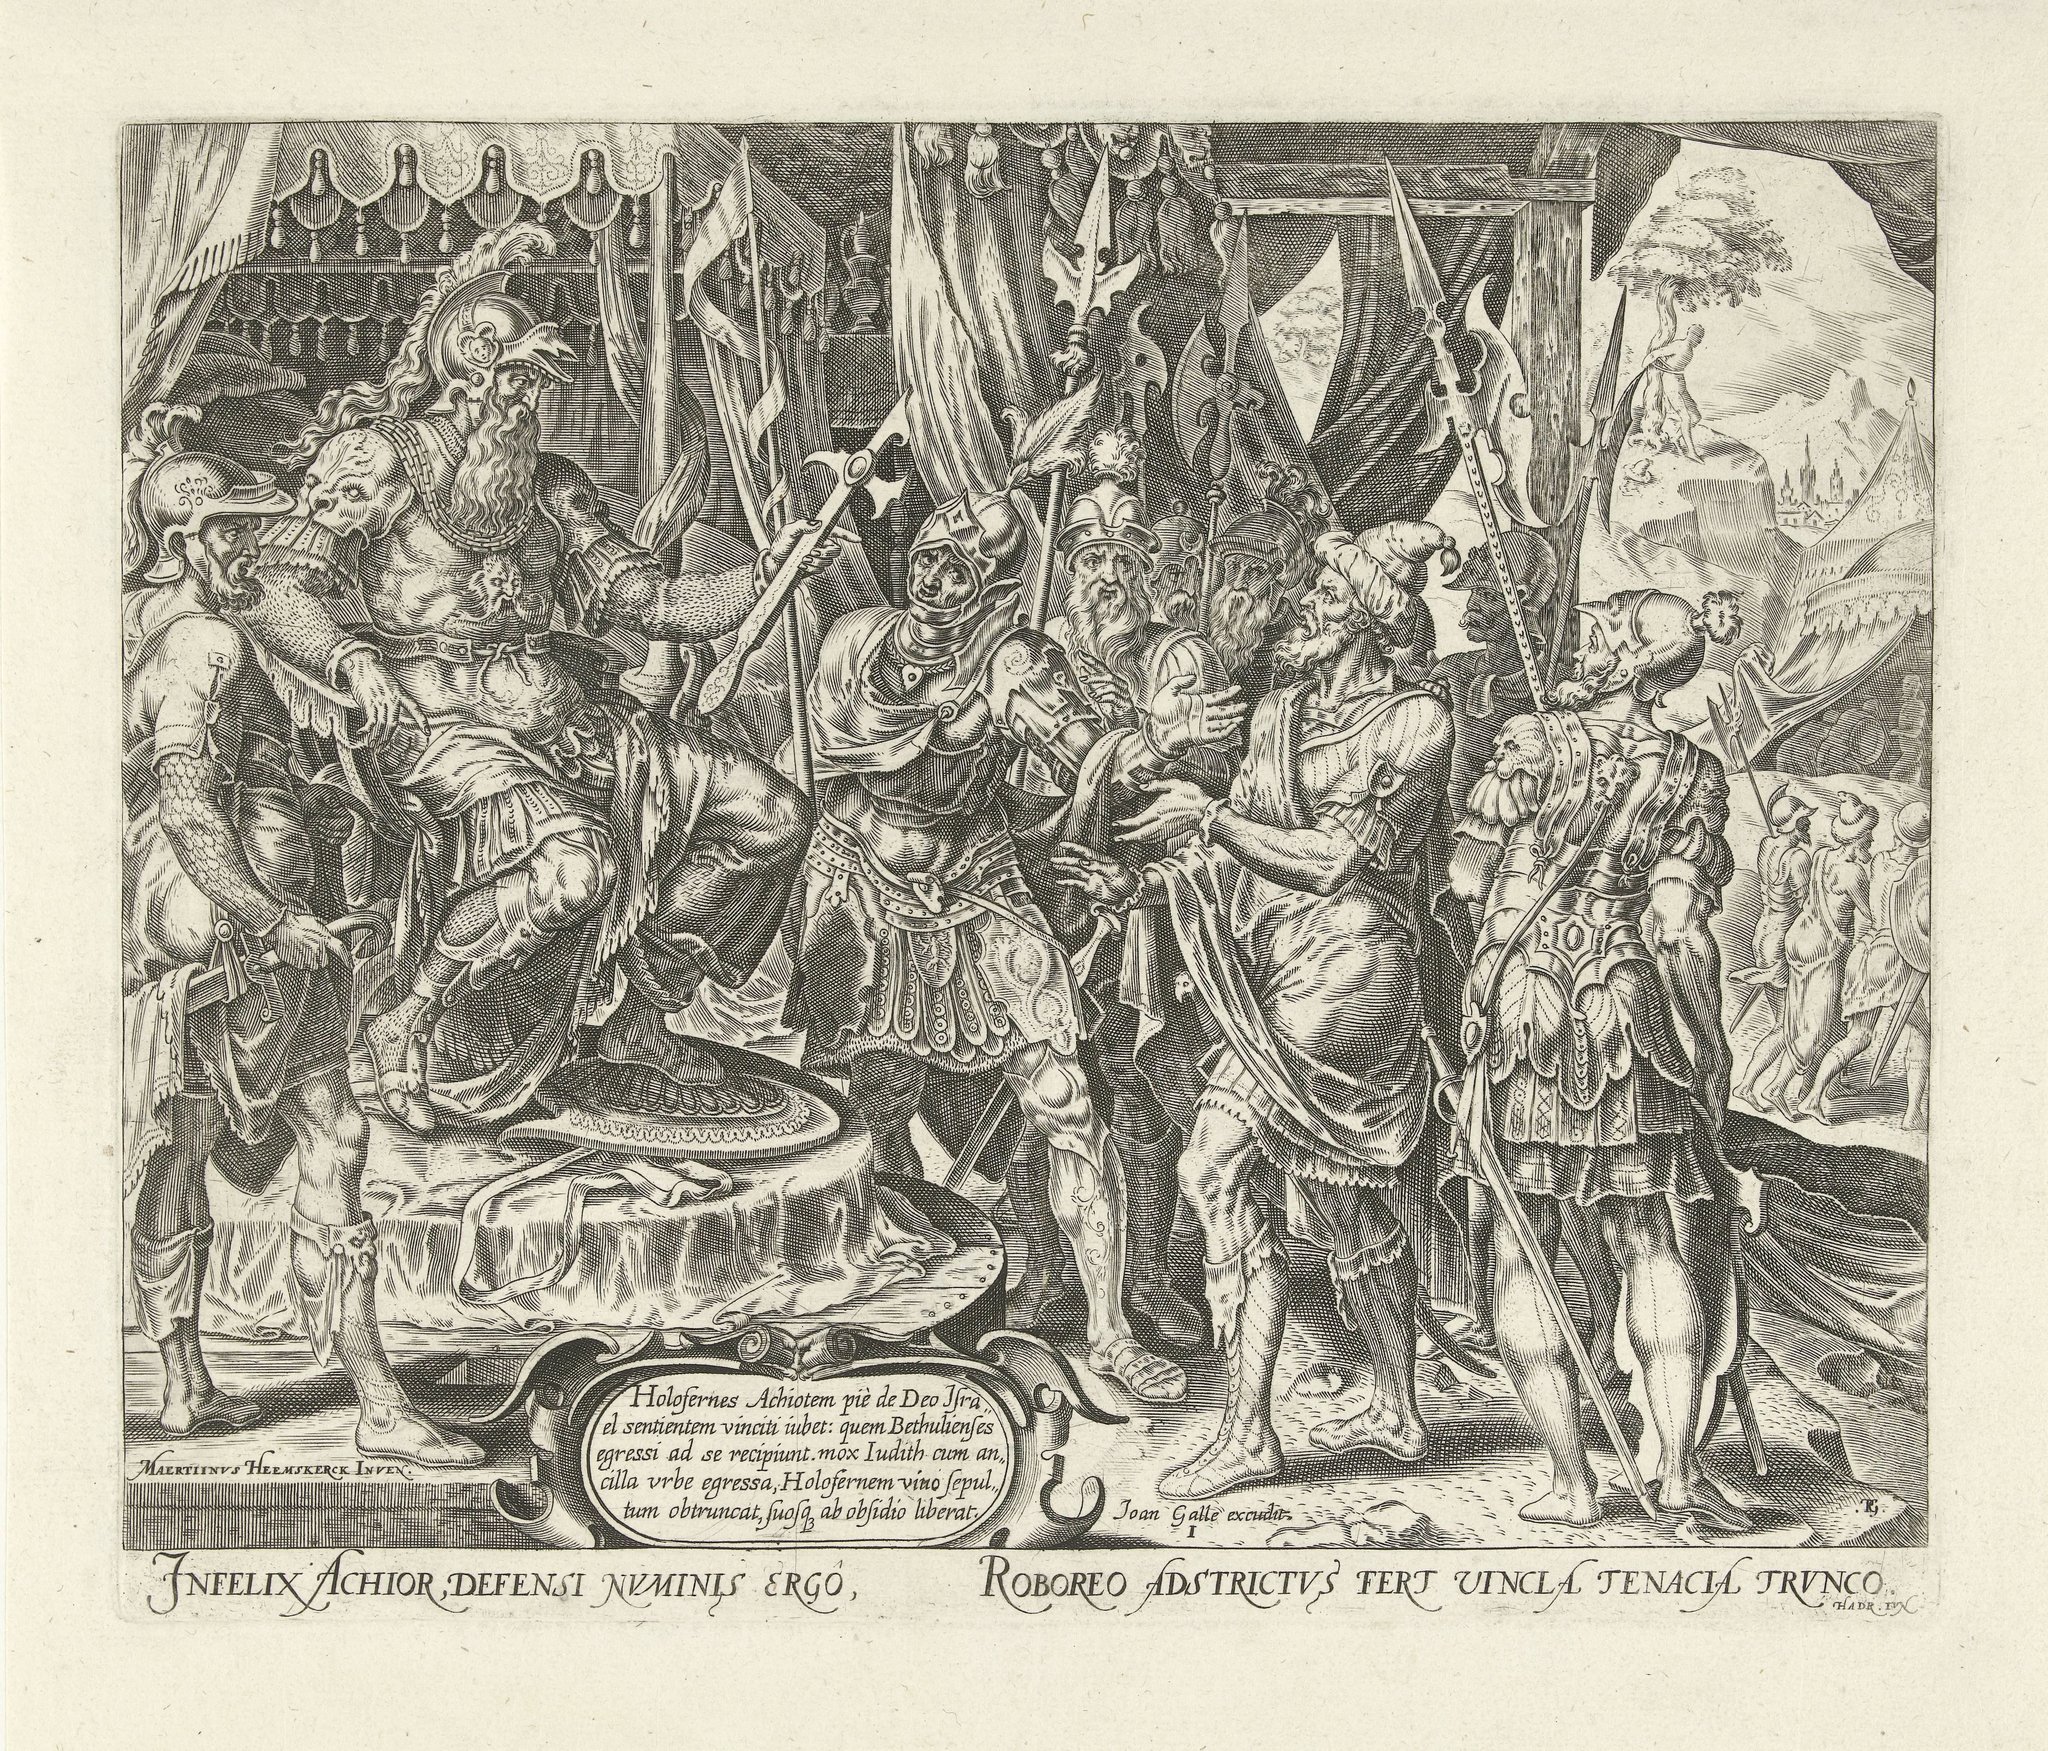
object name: print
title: Geschiedenis van Judit en Holofernes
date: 1627-1678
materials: paper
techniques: engraving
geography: antwerp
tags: judith and holofernes (judith 8-16)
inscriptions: collector's mark: Lugt 2228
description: Holofernes zit in een tent van het legerkamp op een troon en luistert naar het bericht van Achior, de aanvoerder van de Ammonieten.